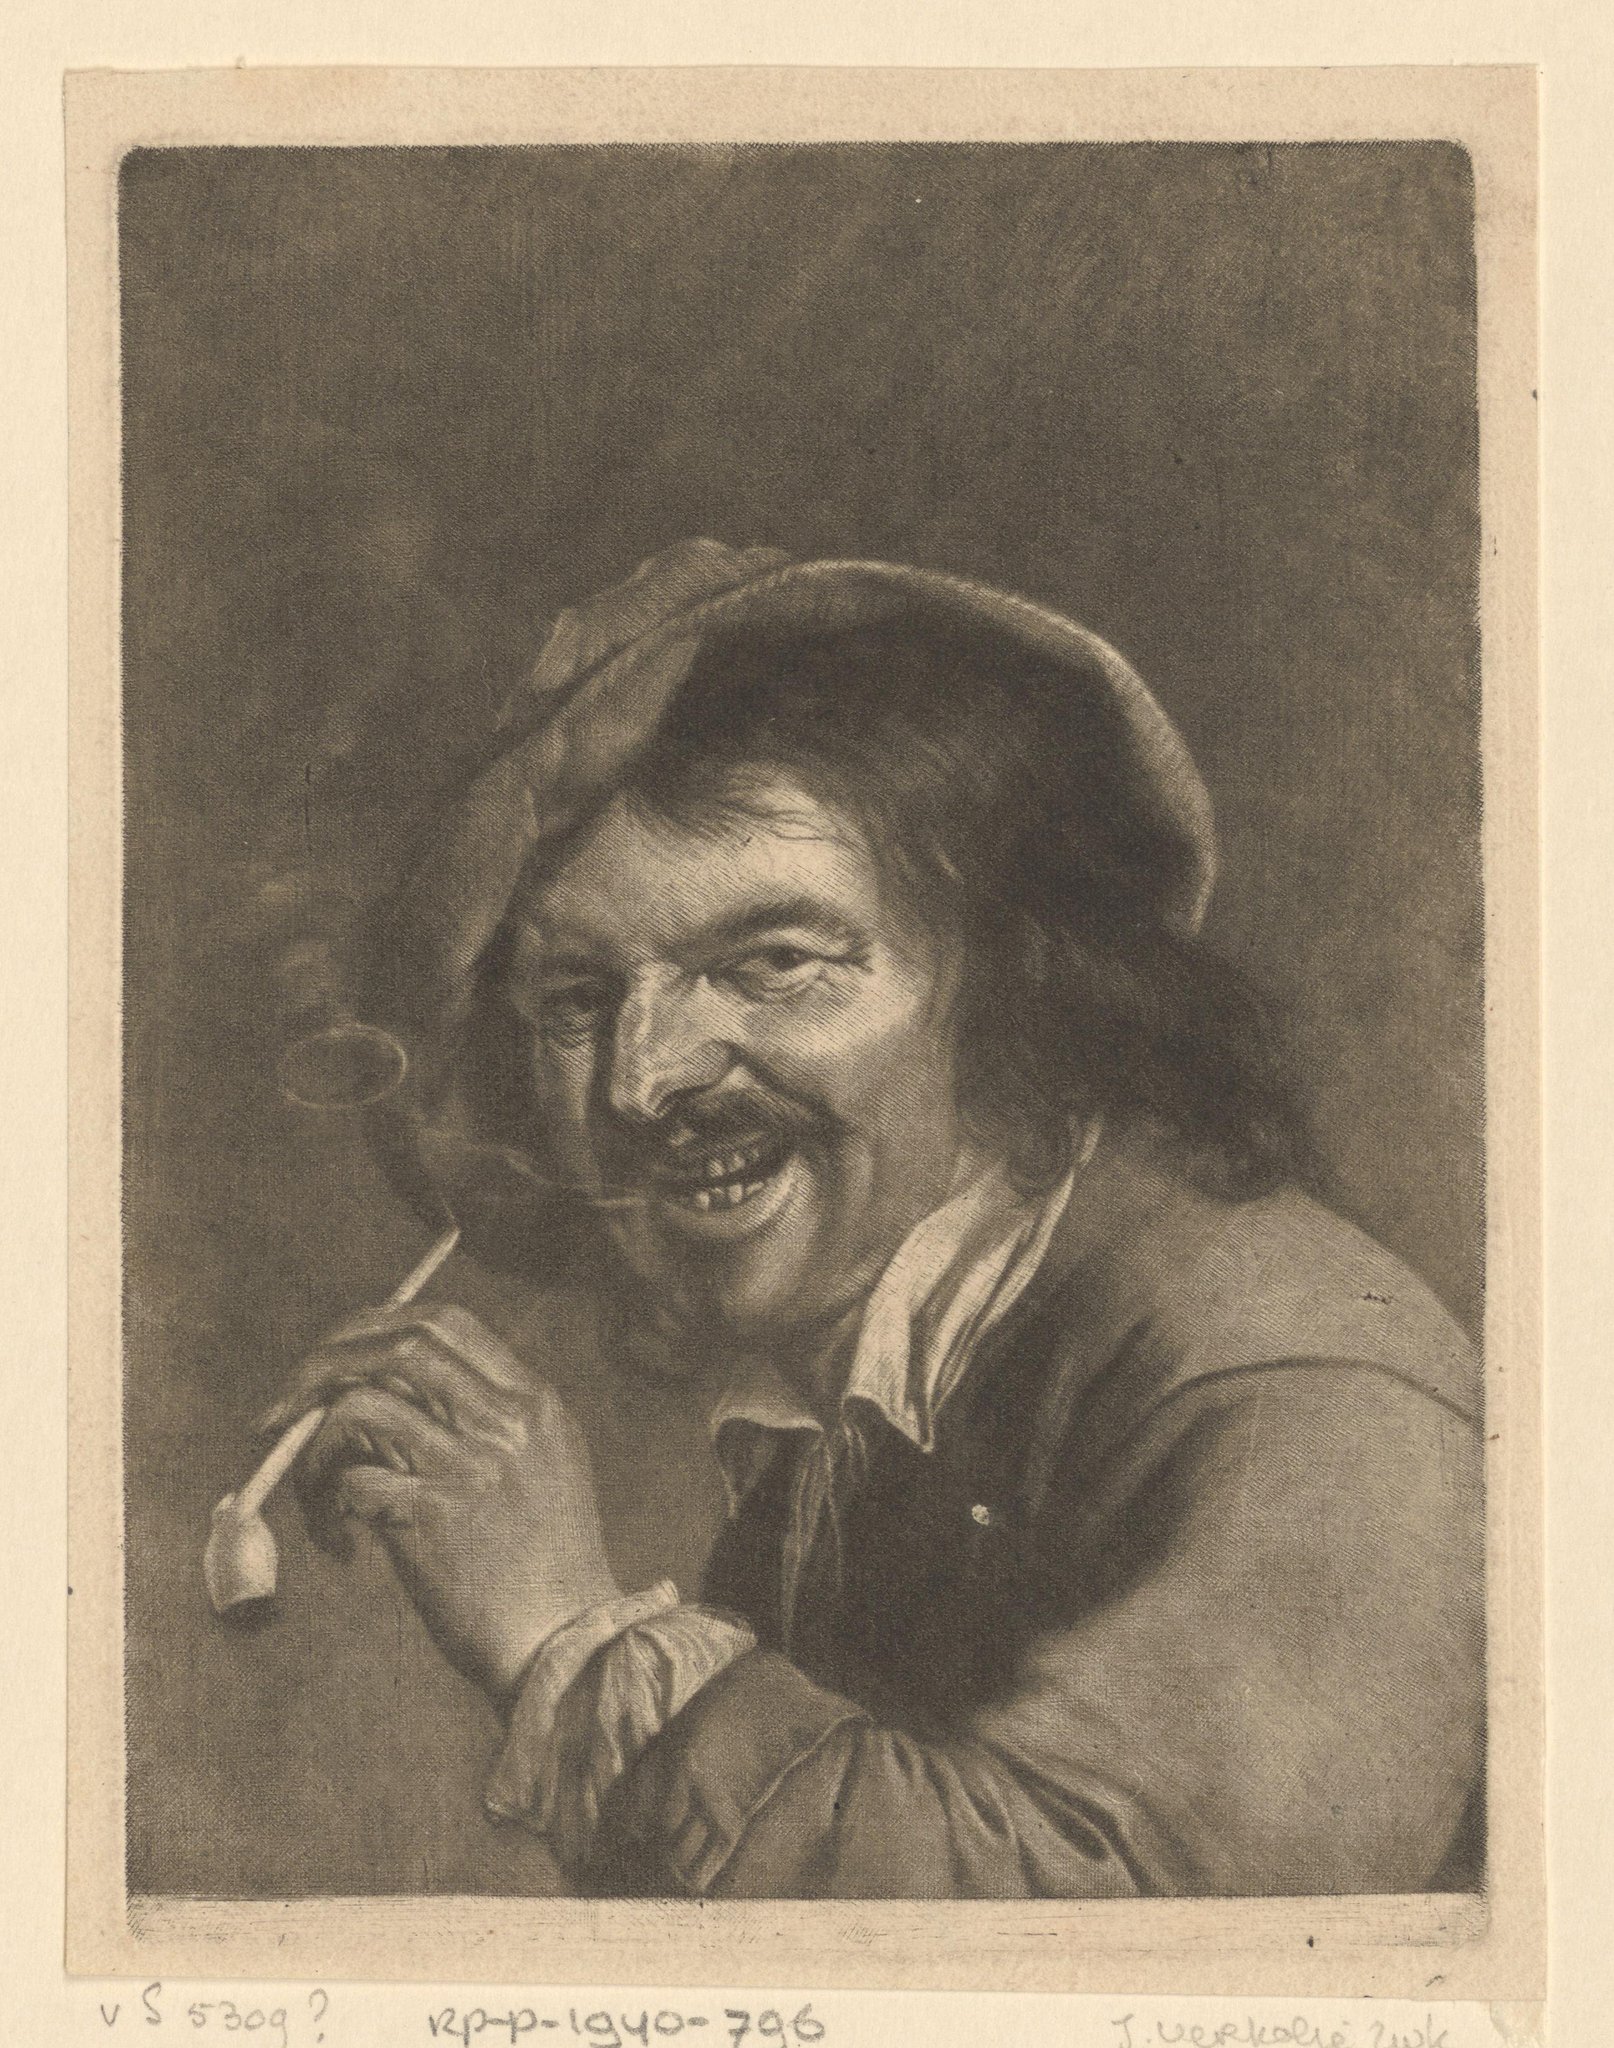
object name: print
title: Portret van een man, mogelijk Jan Havicksz. Steen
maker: jan verkolje (i)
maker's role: draughtsman, painter, print maker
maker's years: 1650-1693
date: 1660-1693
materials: paper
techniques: mezzotint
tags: leiden, jan havicksz. steen, historical persons, smell, smelling (one of the five senses), pipe ~ tobacco, portrait, self-portrait of artist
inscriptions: collector's mark: Lugt 2760, collector's mark: Lugt 2228